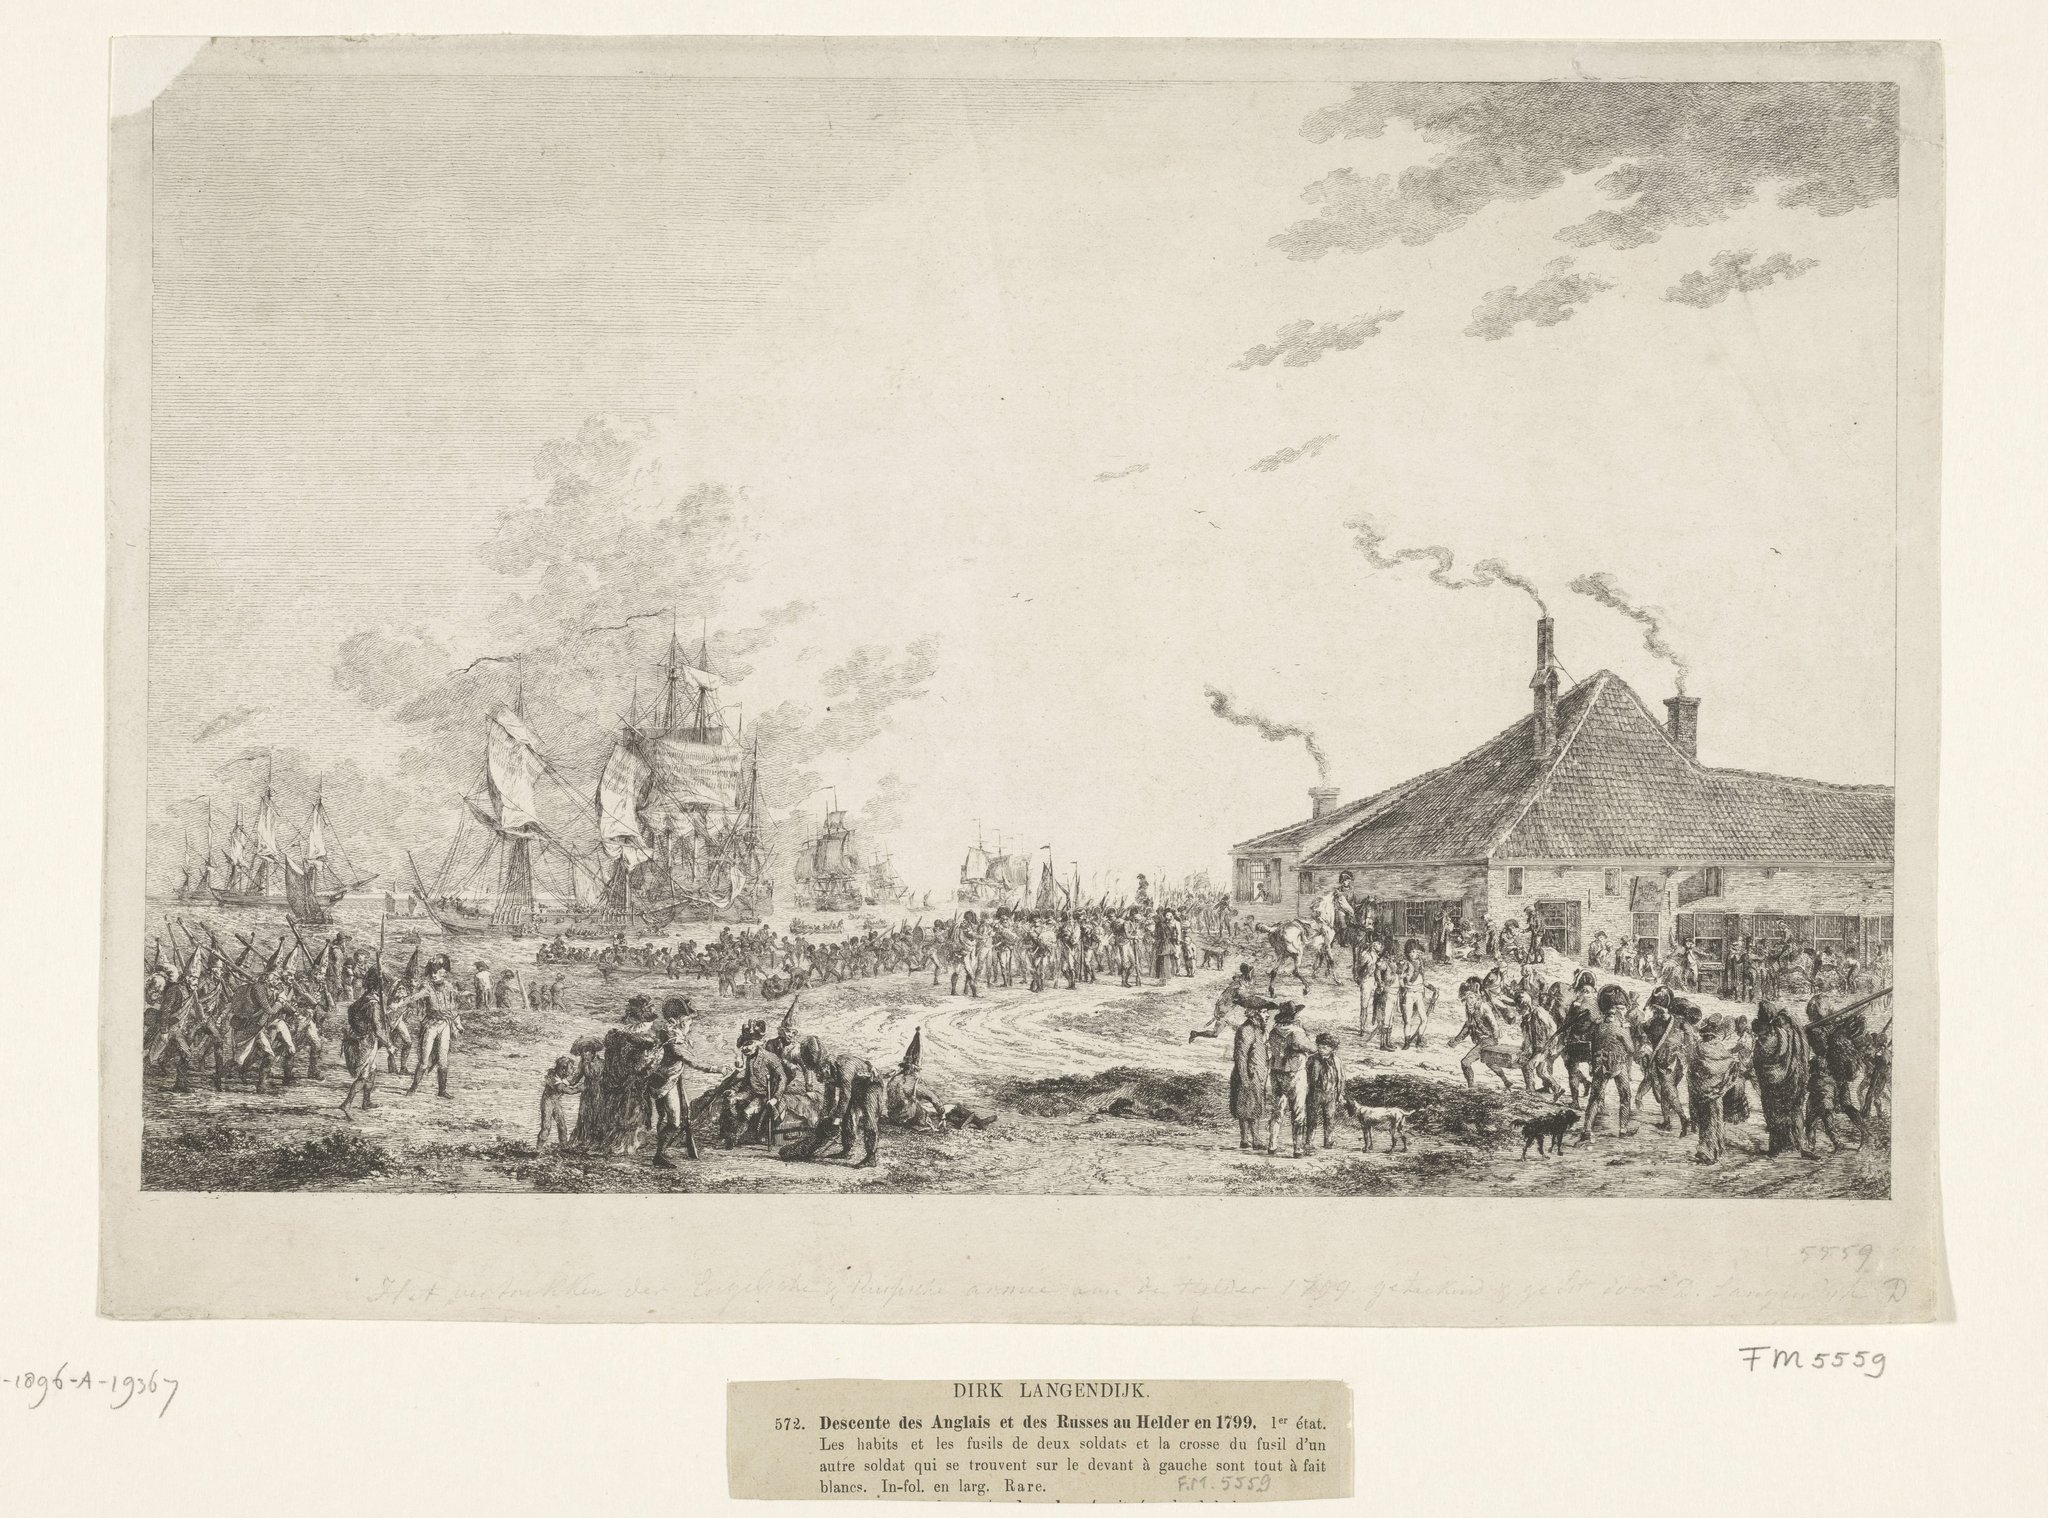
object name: print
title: Vertrek van de Engelse en Russische troepen uit Den Helder, 1799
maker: joannes bemme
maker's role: print maker, printer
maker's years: 1775-1841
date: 1799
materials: paper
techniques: etching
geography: den helder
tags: transport, train (military) (+ sailing-ships), beach, den helder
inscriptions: collector's mark: Lugt 2228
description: De soldaten van de Brits-Russische invasiemacht verlaten Den Helder op 29 november 1799. Op de achtergrond rechts het logement 'Het wapen van Haarlem', links vertrekken manschappen in sloepen naar de gereedliggende schepen.